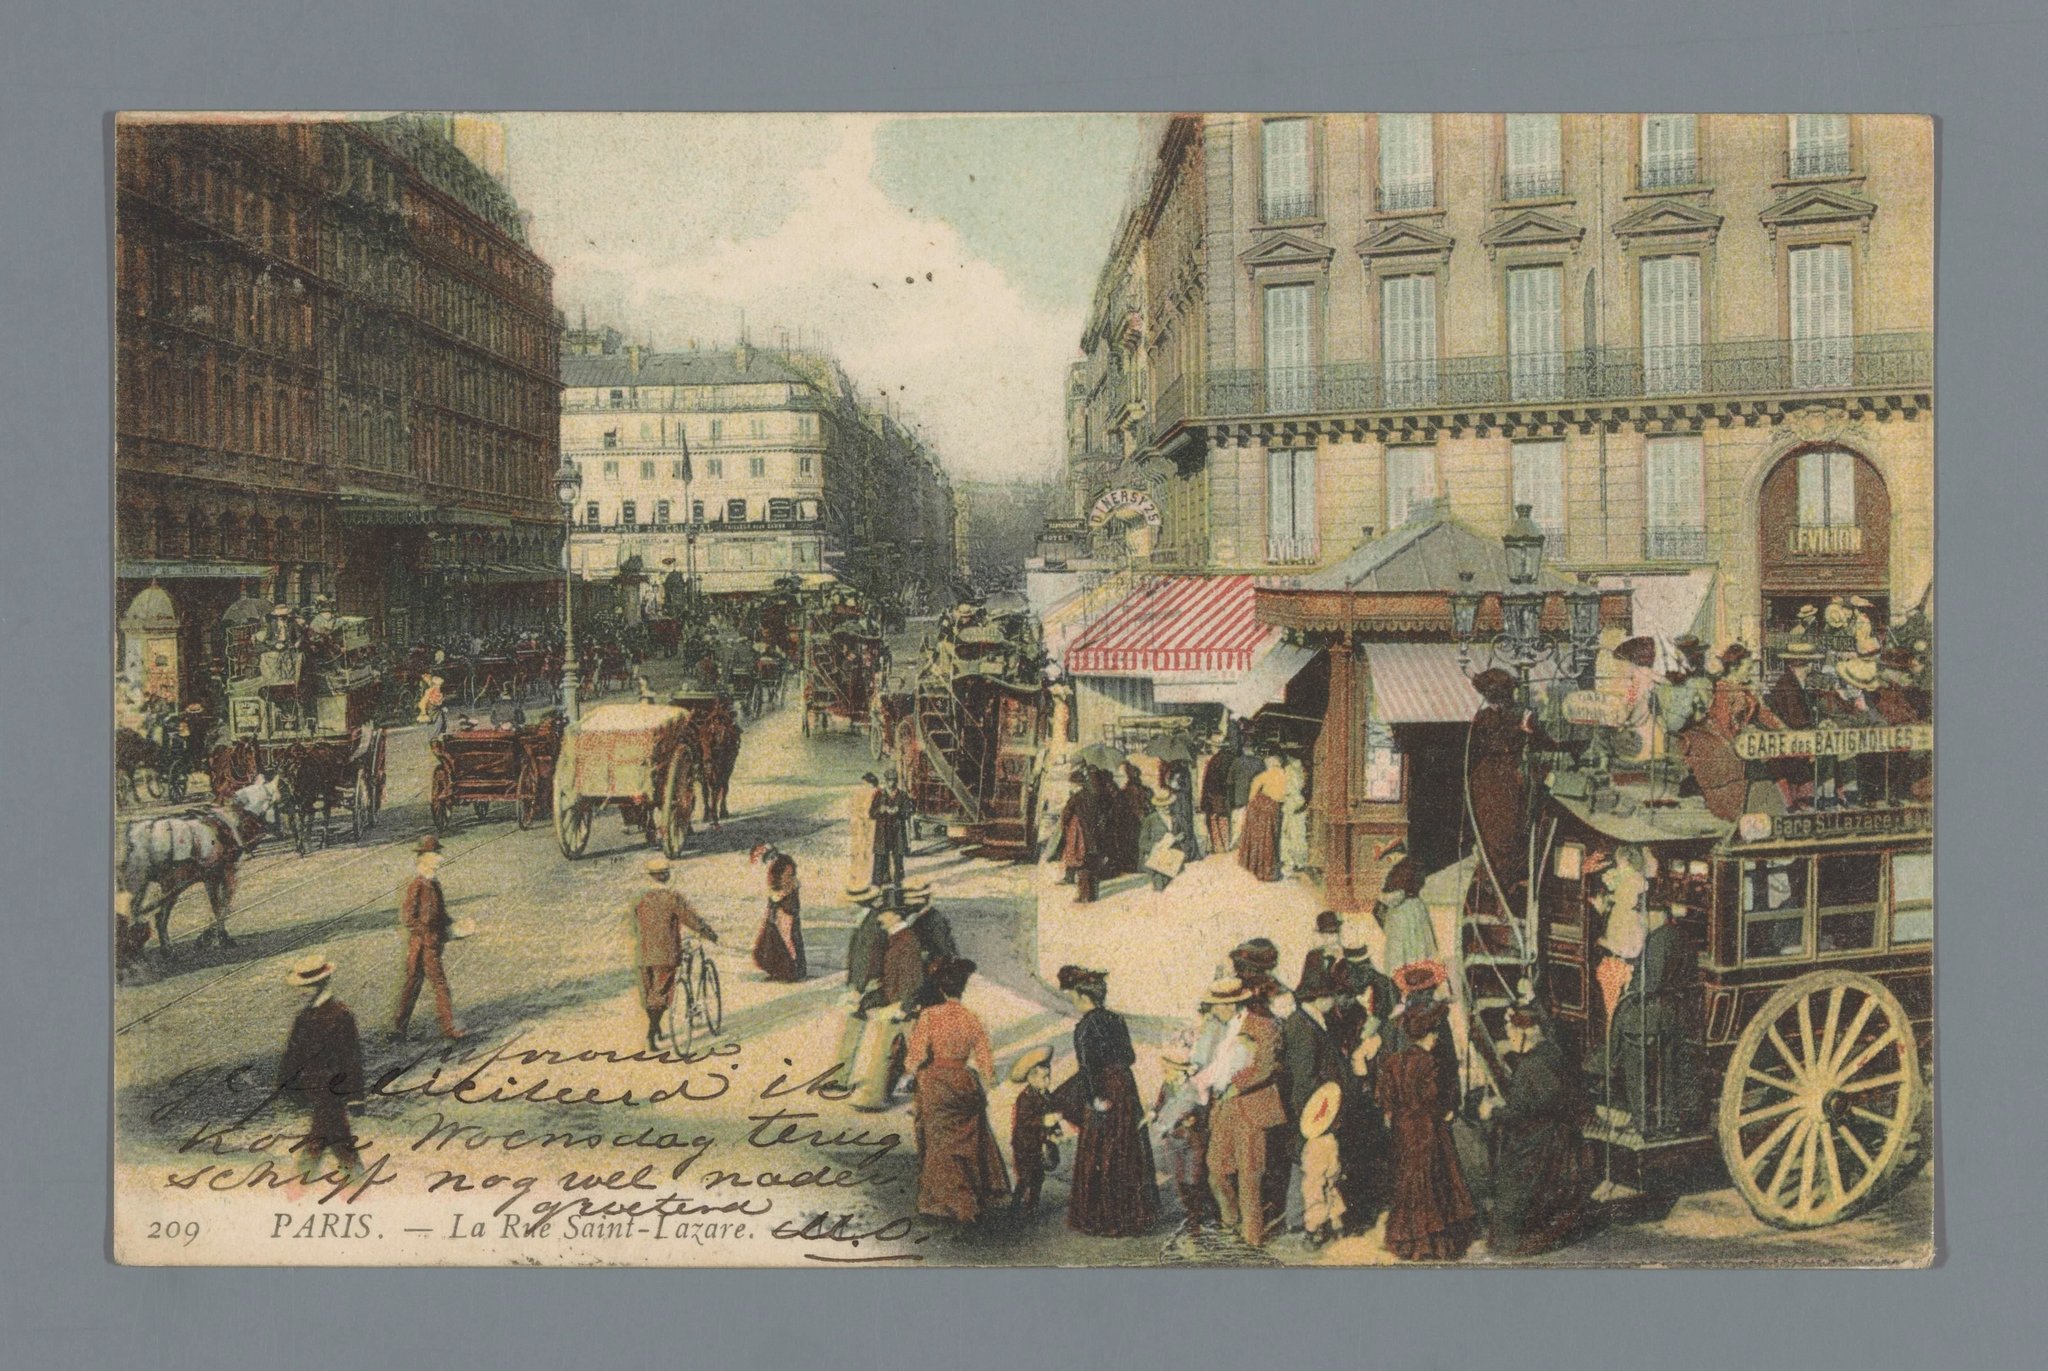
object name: ansichtkaart, prentbriefkaart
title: Paris. - La Rue Saint-Lazare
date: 1905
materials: paper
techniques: photograph, writing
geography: paris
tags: diligence, omnibus, horse-tram, city-view in general; 'veduta', four-wheeled, animal-drawn vehicle, e.g.: cab, carriage, coach, paris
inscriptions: annotation: ‘Juffrouw. Gefeliciteerd ik kom woensdag terug schrijf nog wel nader. Groeten [...]’, number: ‘209’